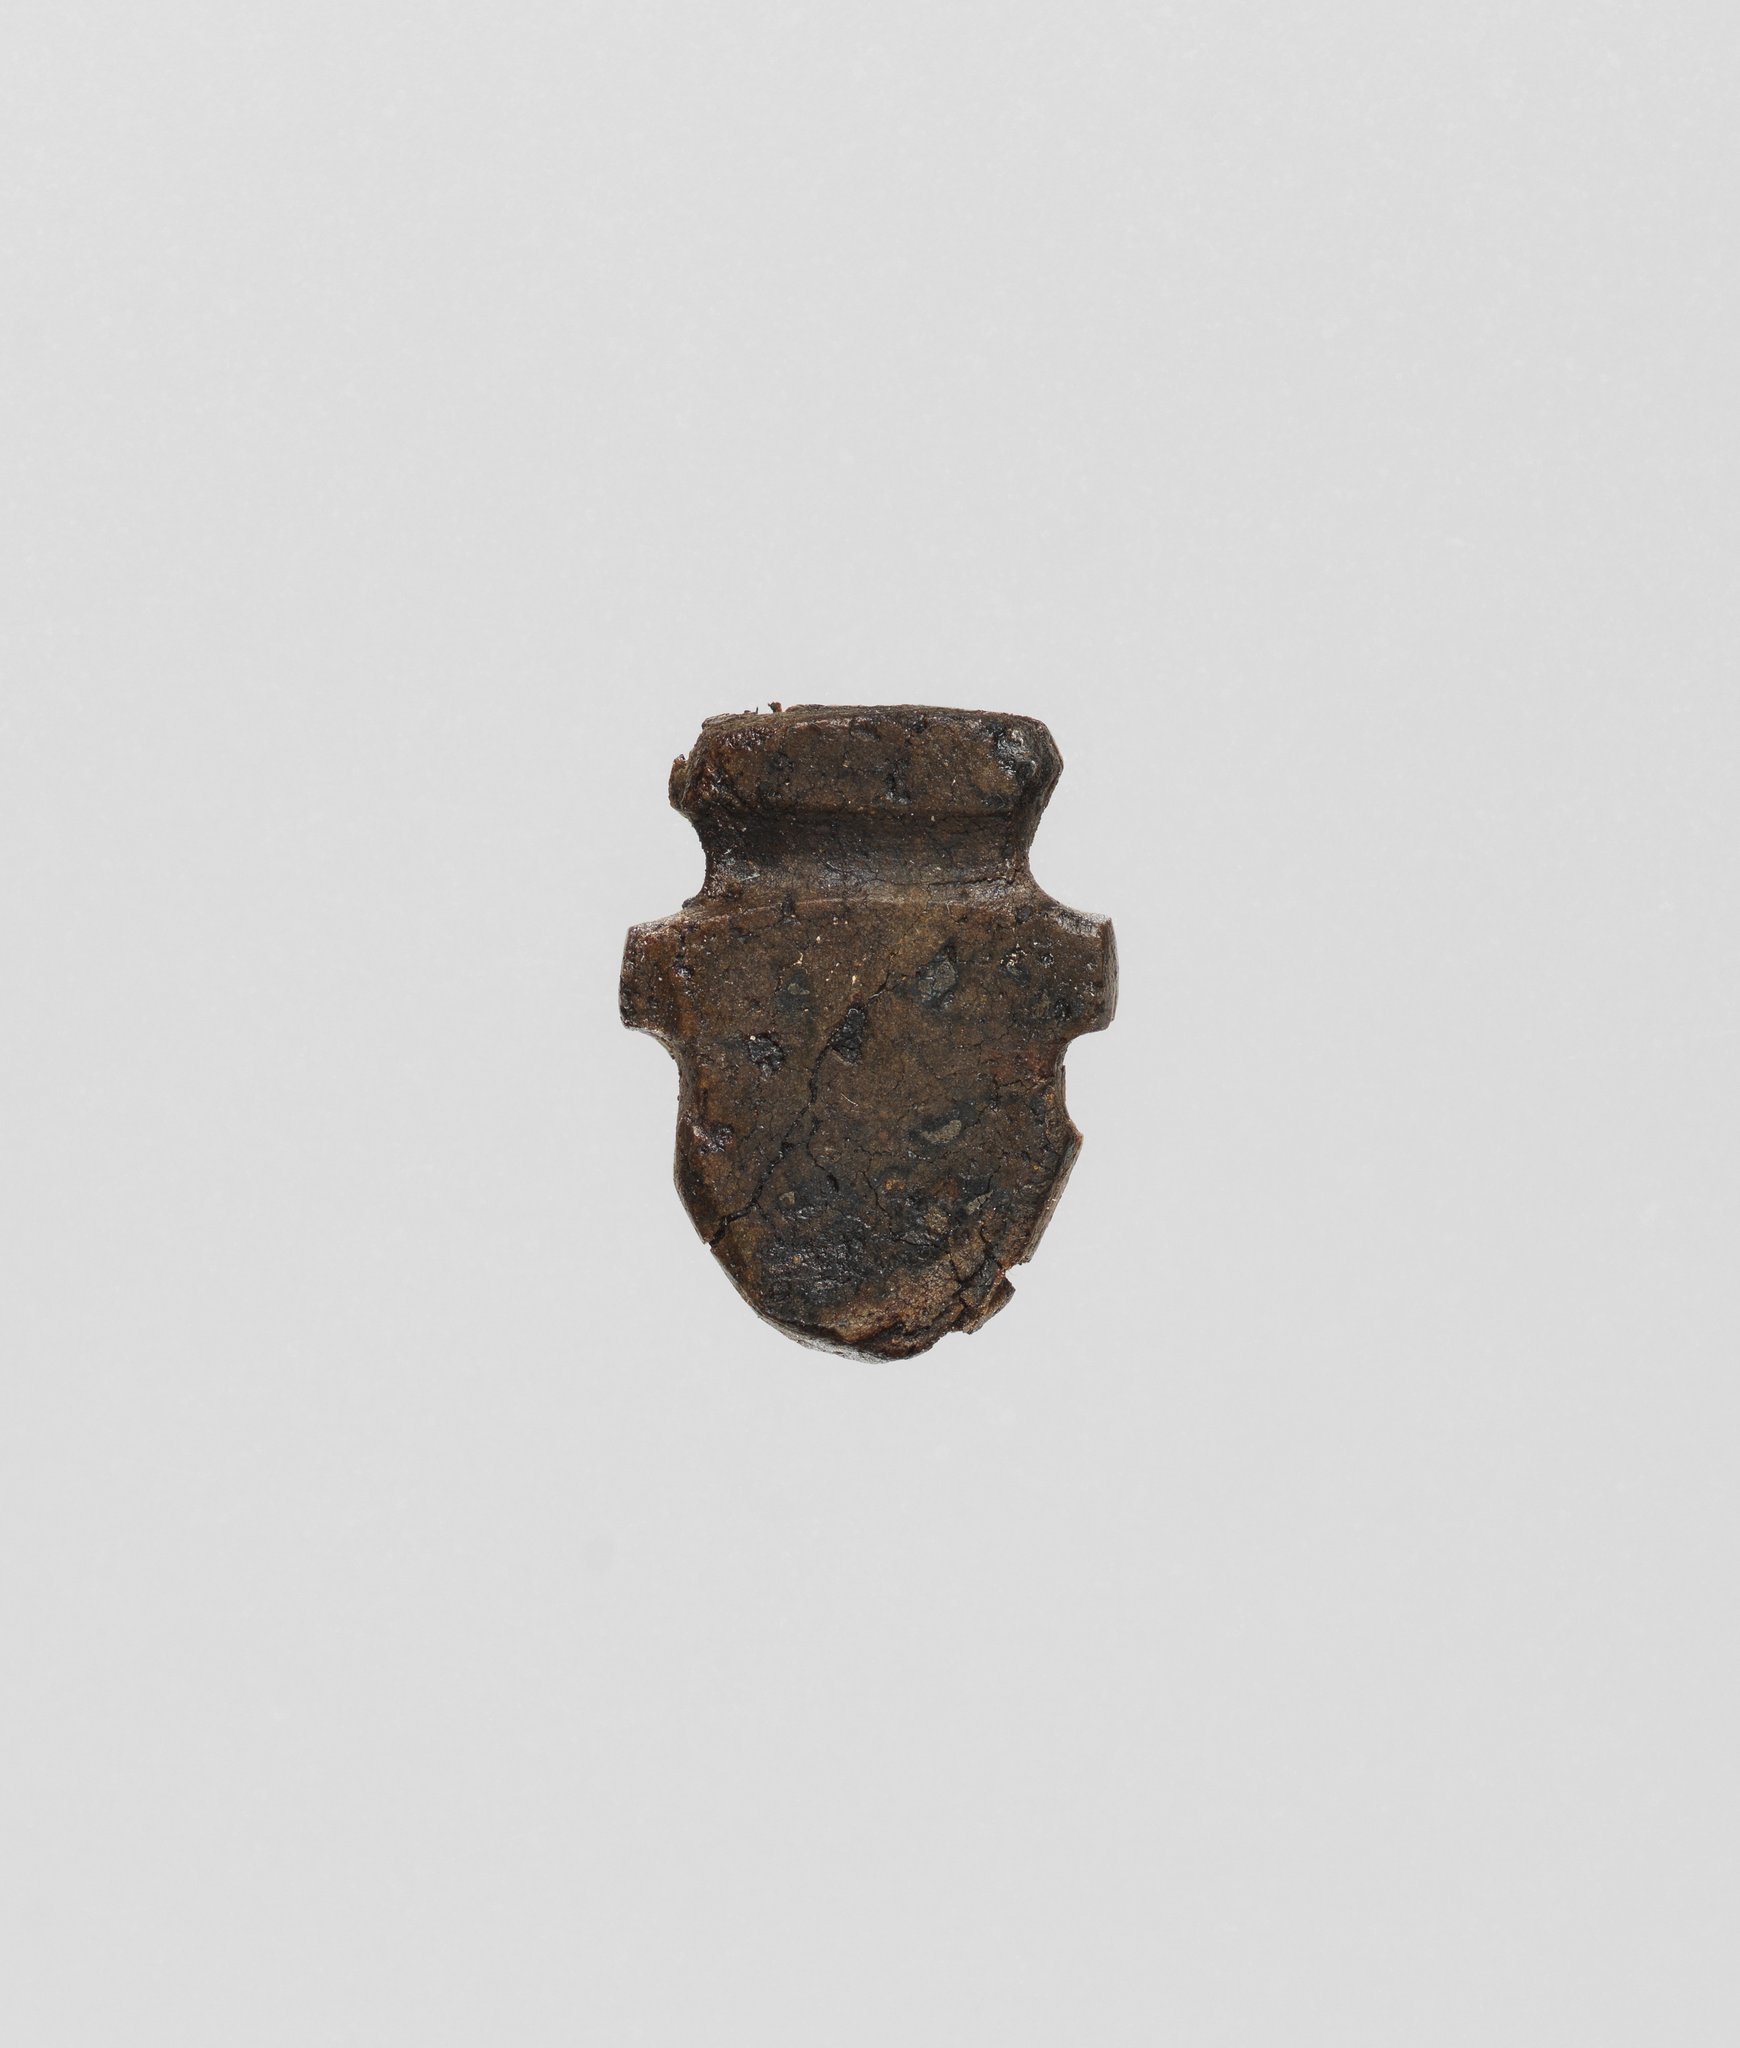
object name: amulet, heart, isetweret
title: Heart Amulet of Isetweret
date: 305-30 BCE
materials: faience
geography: egypt